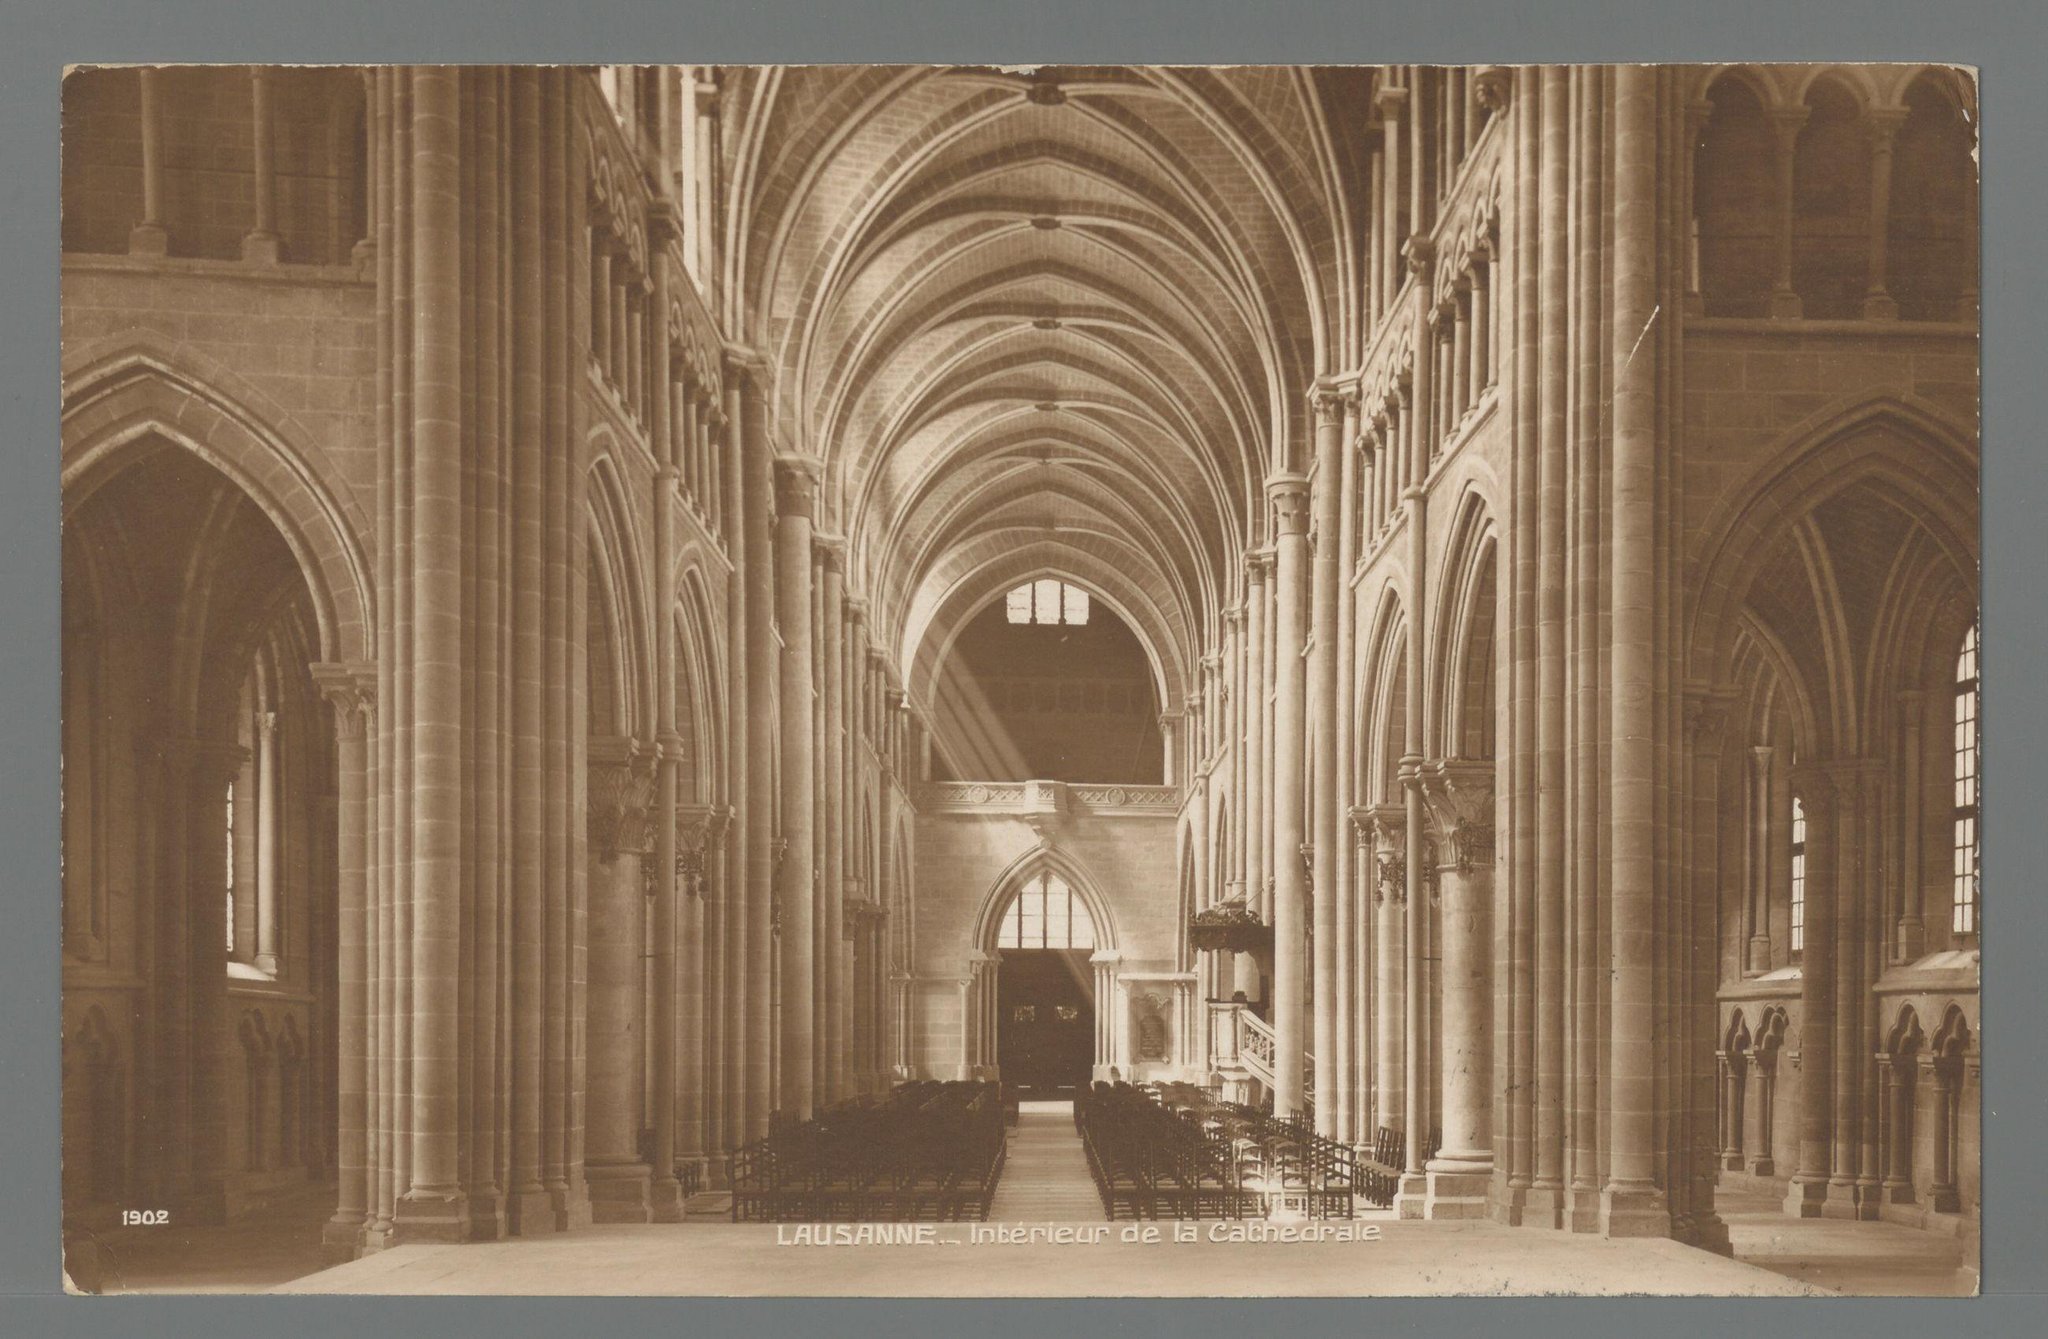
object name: ansichtkaart, prentbriefkaart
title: Lausanne. Intérieur de la Cathédrale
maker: Anonymous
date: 1905-1914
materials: photographic support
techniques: photography, writing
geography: lausanne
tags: interior of church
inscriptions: postage stamp